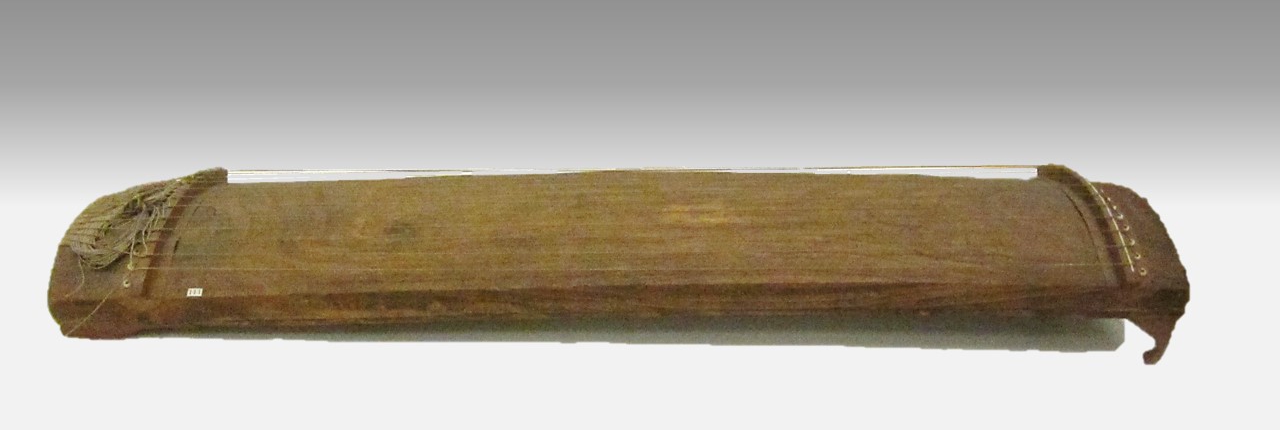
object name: han goto or han koto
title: Han Goto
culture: japanese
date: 1801-1900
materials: ivory, metal, silk, wood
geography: japan